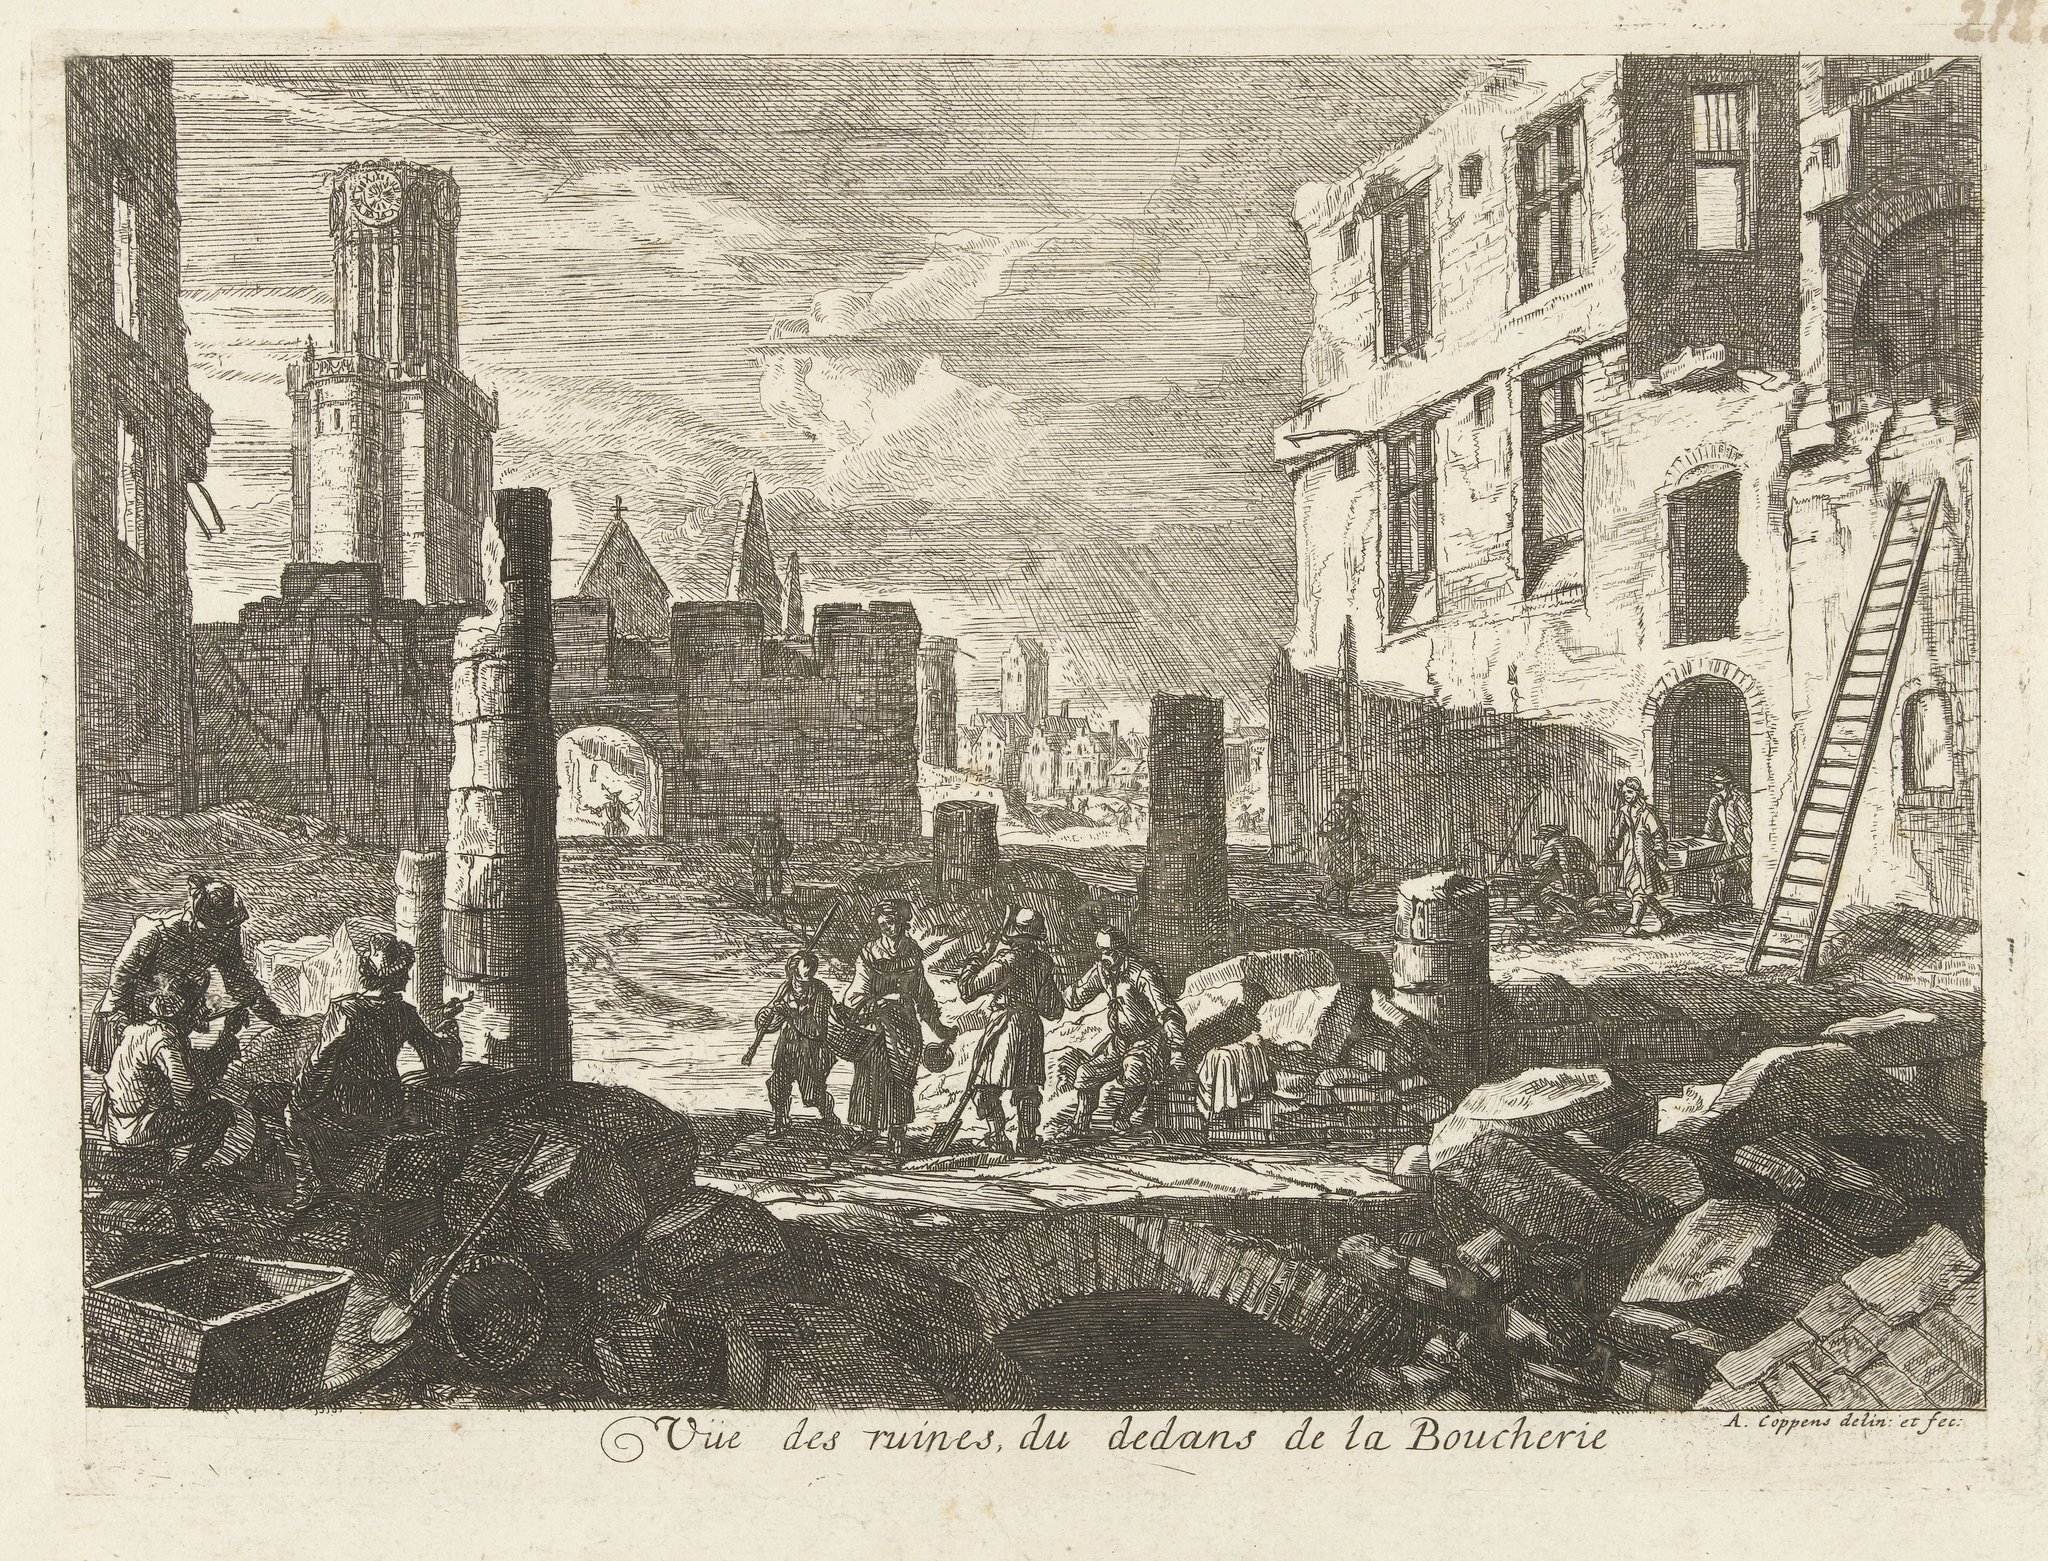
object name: print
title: Ruïnes in de Beenhouwersstraat te Brussel, 1695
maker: augustin coppens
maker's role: print maker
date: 1695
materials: paper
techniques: etching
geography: brussels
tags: devastated, ruined place or city (~ warfare), brussels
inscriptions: collector's mark: Lugt 2228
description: Voorstelling van de ruïnes in de Beenhouwersstraat te Brussel na het bombardement door de Fransen, 13-15 augustus 1695. Negende prent in de reeks van twaalf.